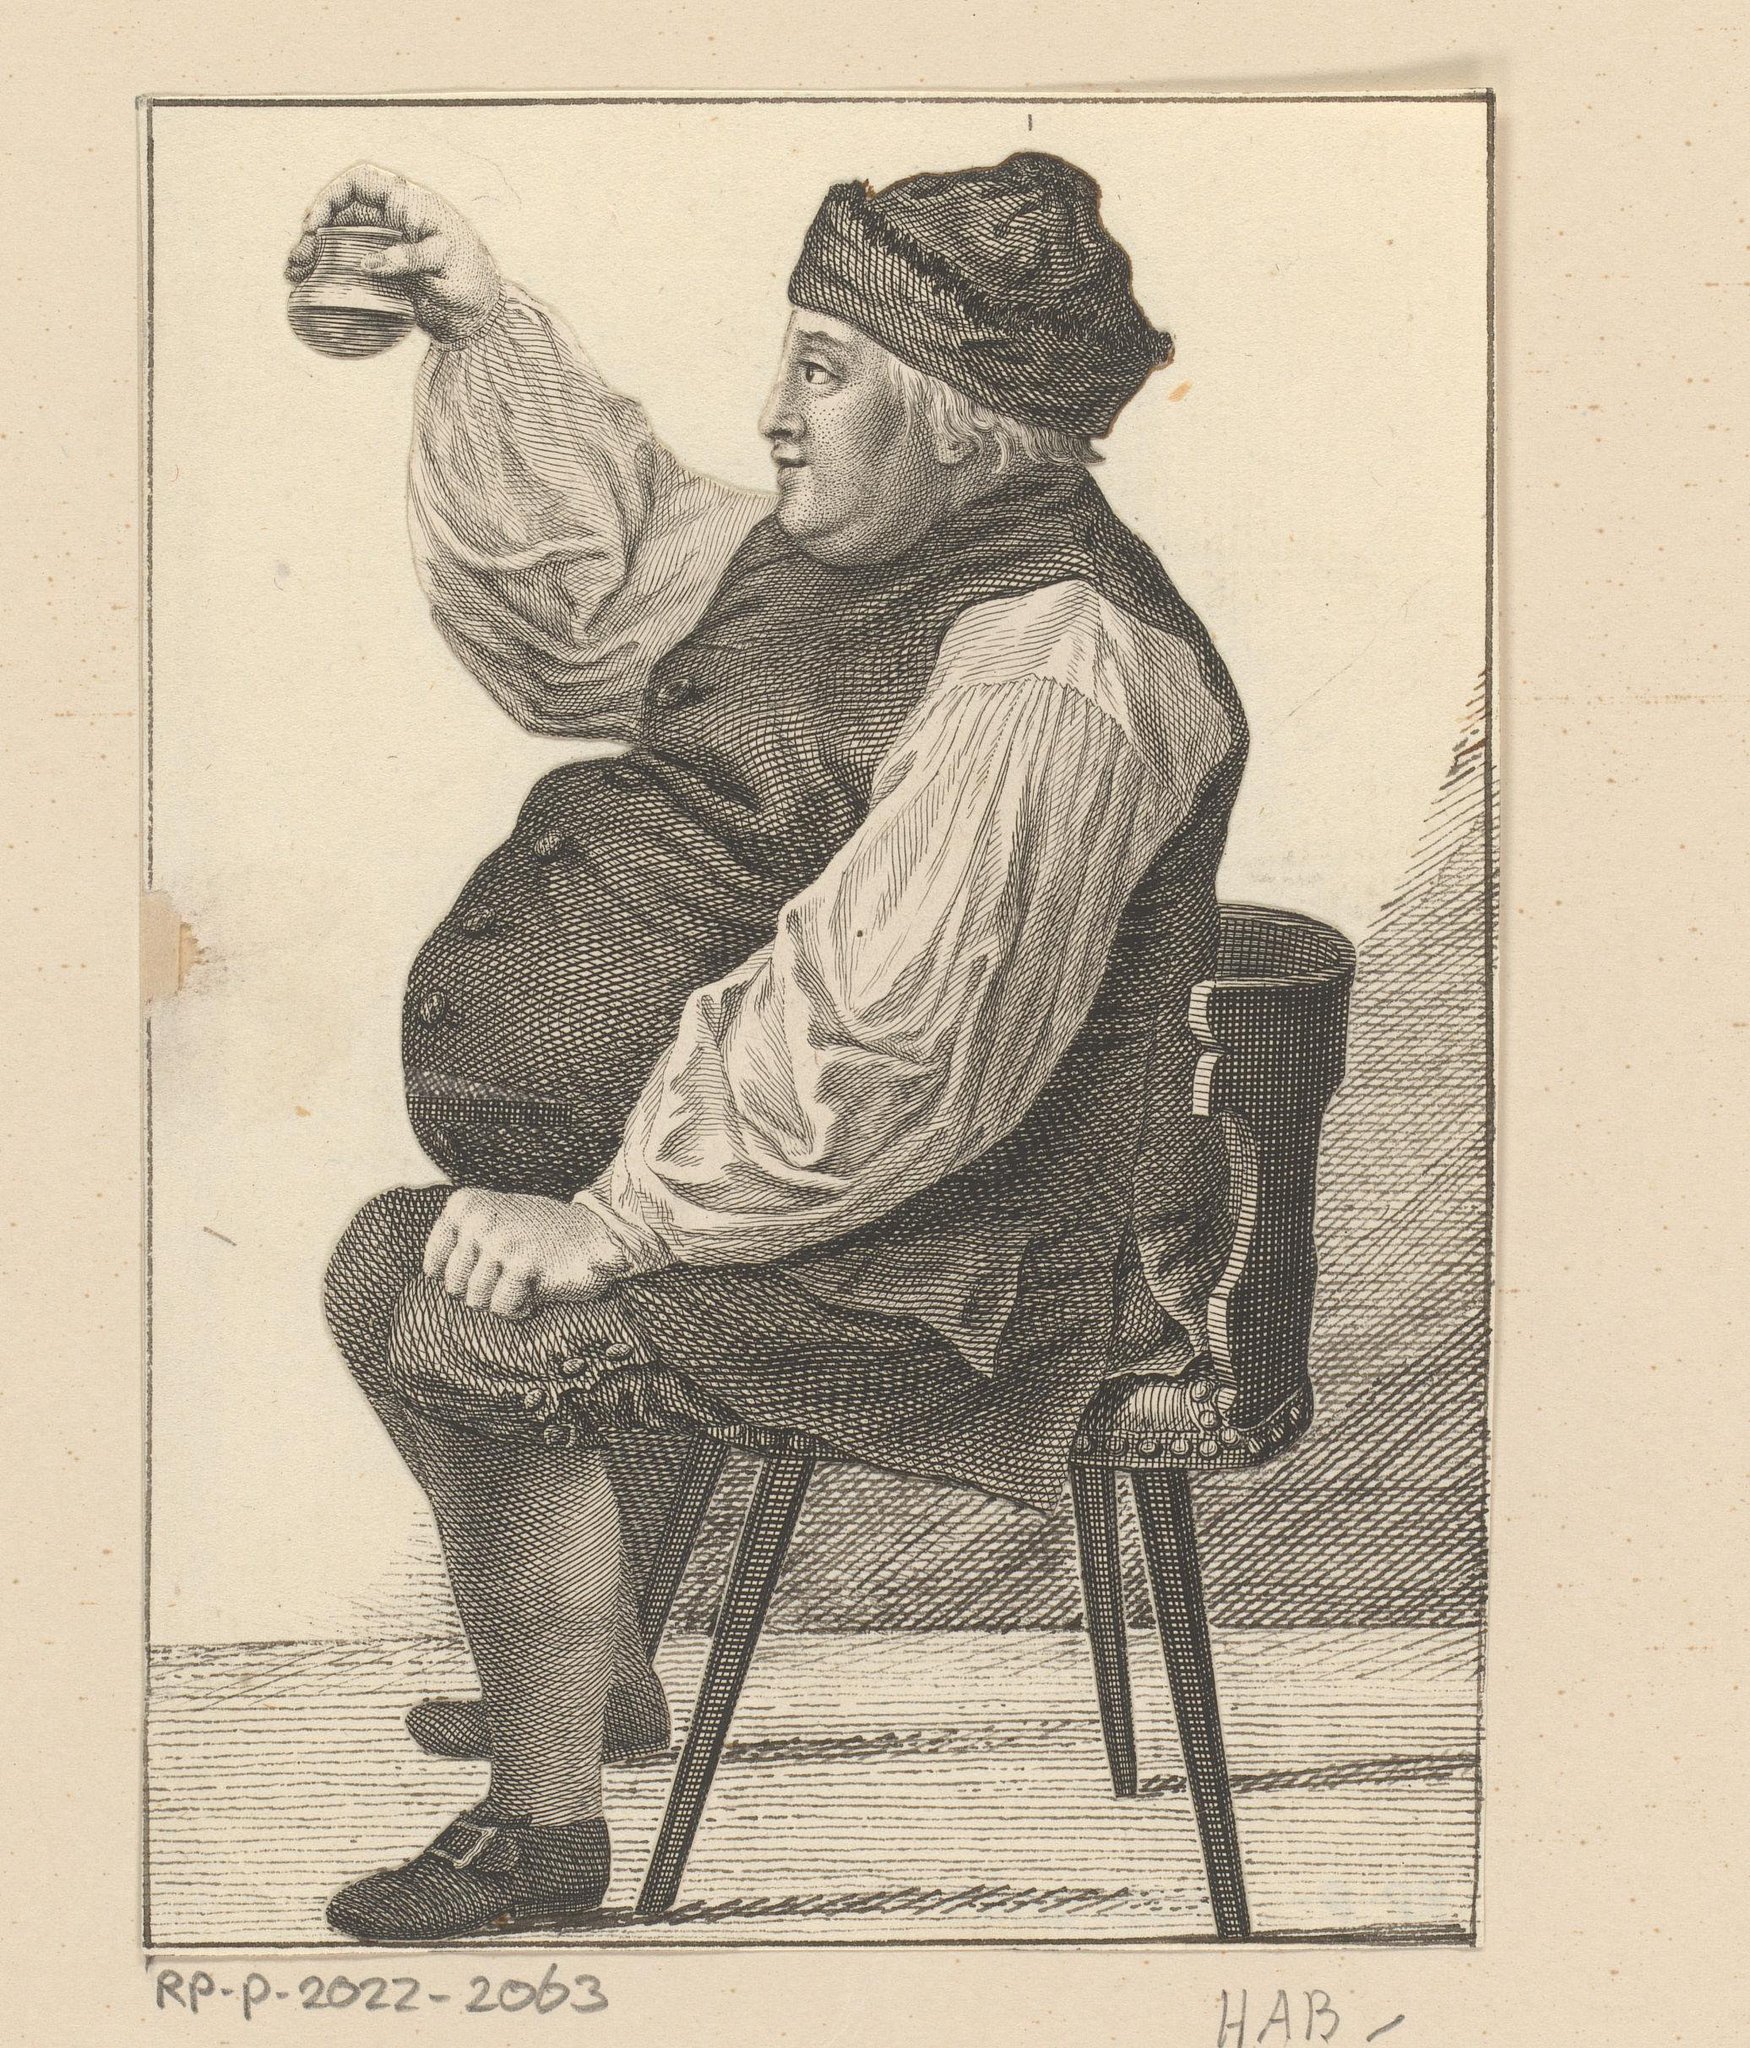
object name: print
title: Portret van Michael Schüppach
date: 1774-1799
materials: ink, paper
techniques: engraving, etching, pen, snipping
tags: pharmacist, druggist, apothecary; pharmacy, drugstore, dispensing chemist (+ portrait of scholar, scientist), historical persons